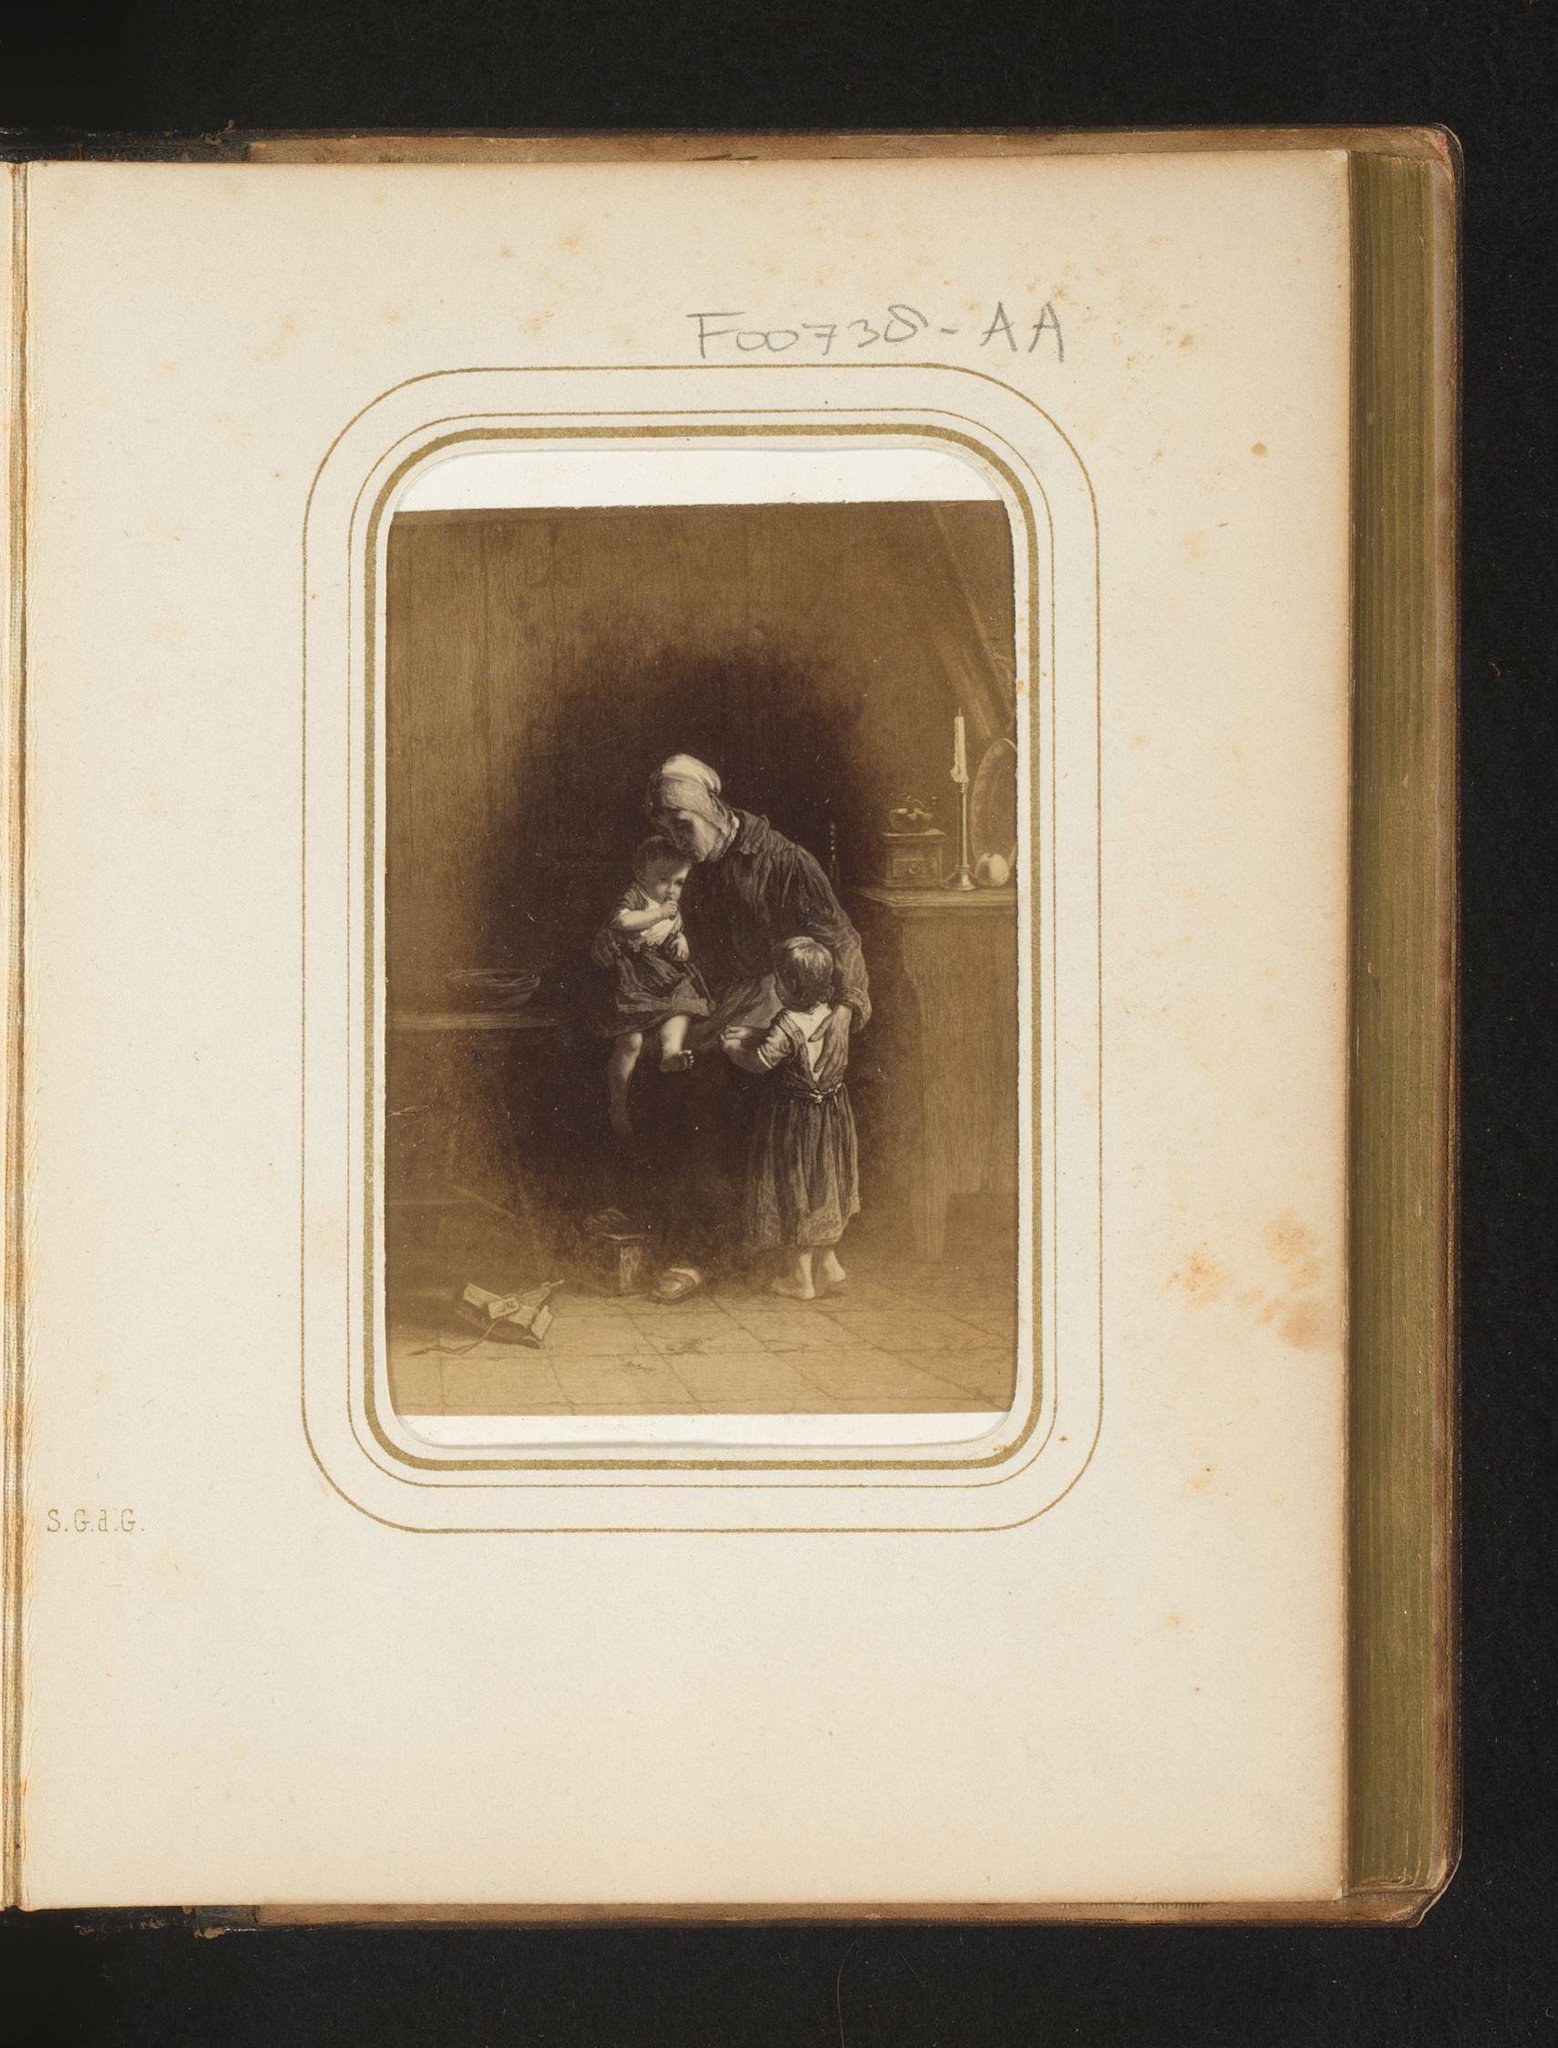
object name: album leaf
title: Fotoreproductie van Les Orphelins door Jozef Israëls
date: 1870-1880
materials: cardboard, photographic support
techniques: albumen print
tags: adult woman, orphans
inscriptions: inscription: ‘Breveté S.G.D.G.’, inscription: ‘190 JOSEPH ISRAELS./ Les Orphelins.’